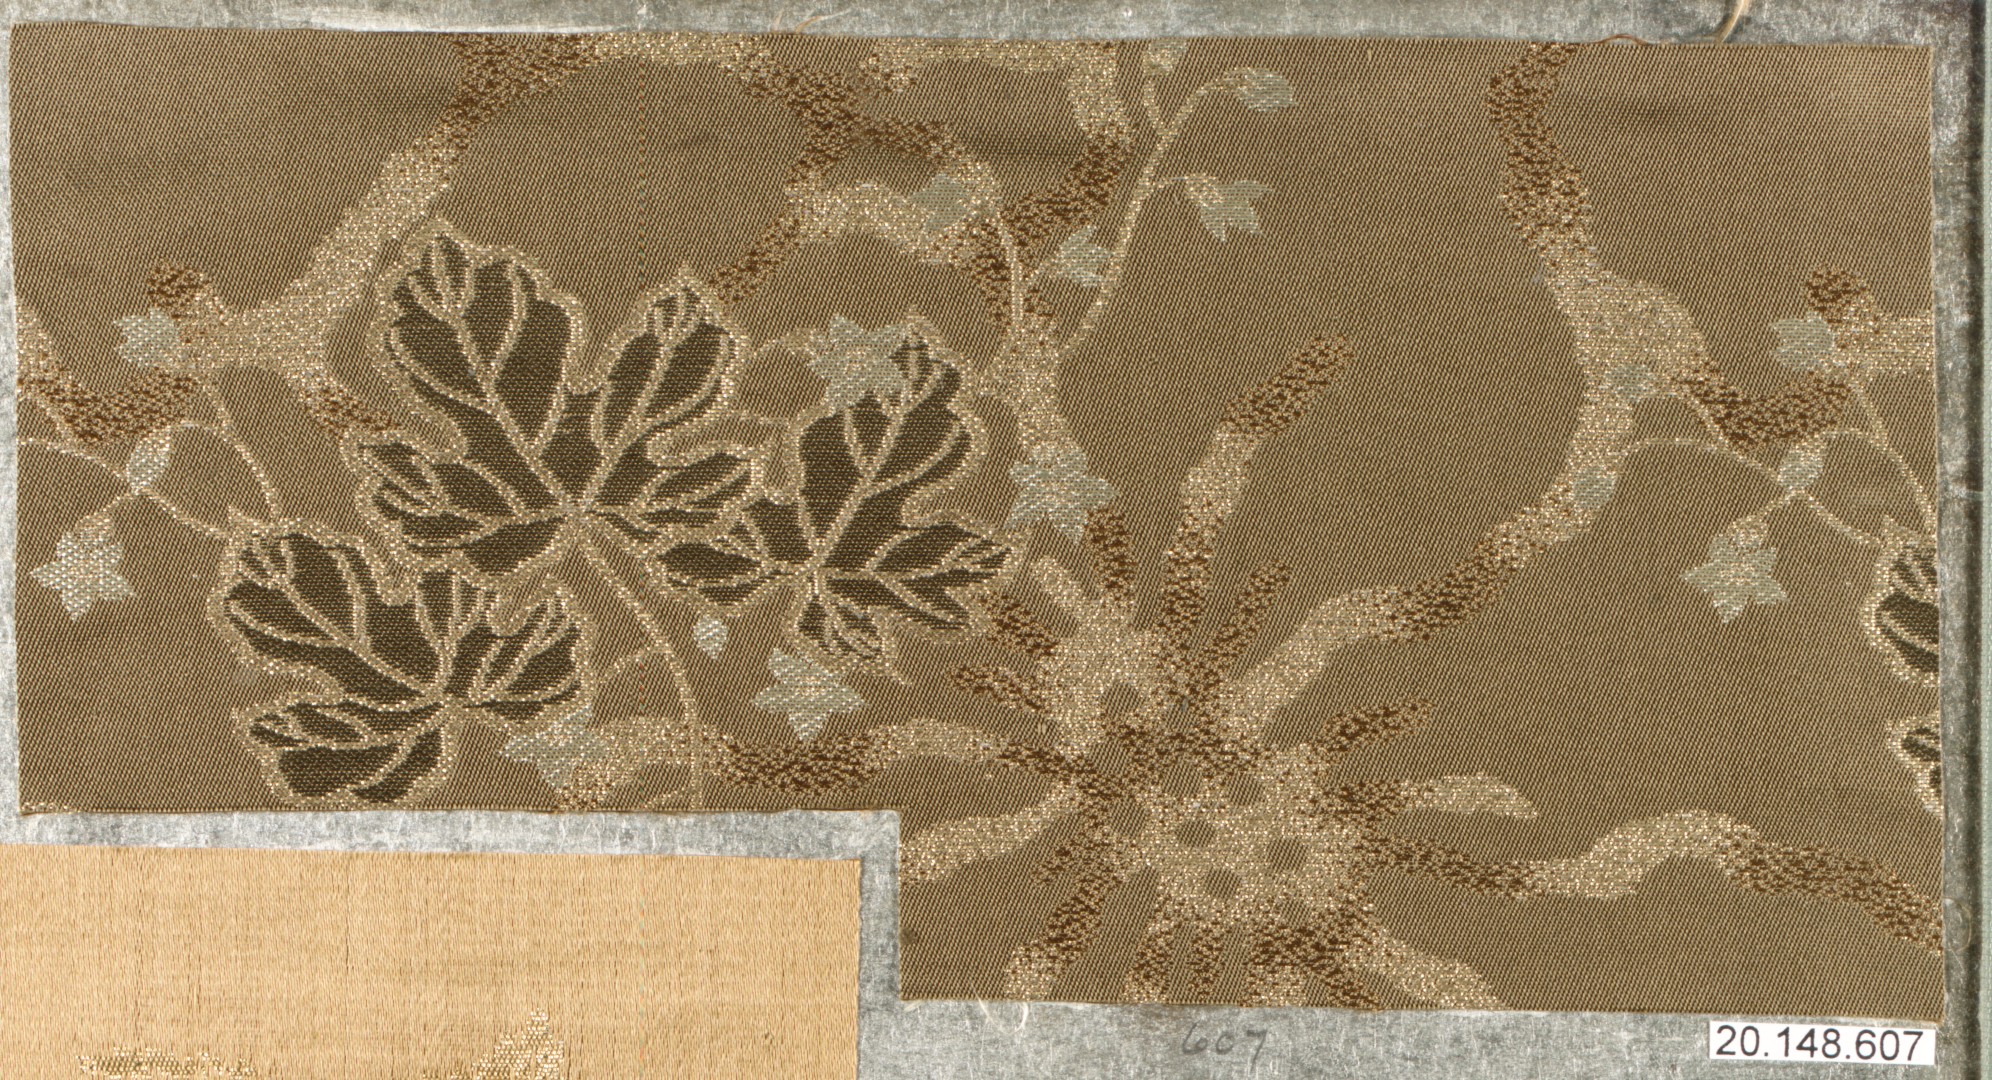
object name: piece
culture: japanese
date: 1701-1800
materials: silk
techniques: compound weave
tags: leaves